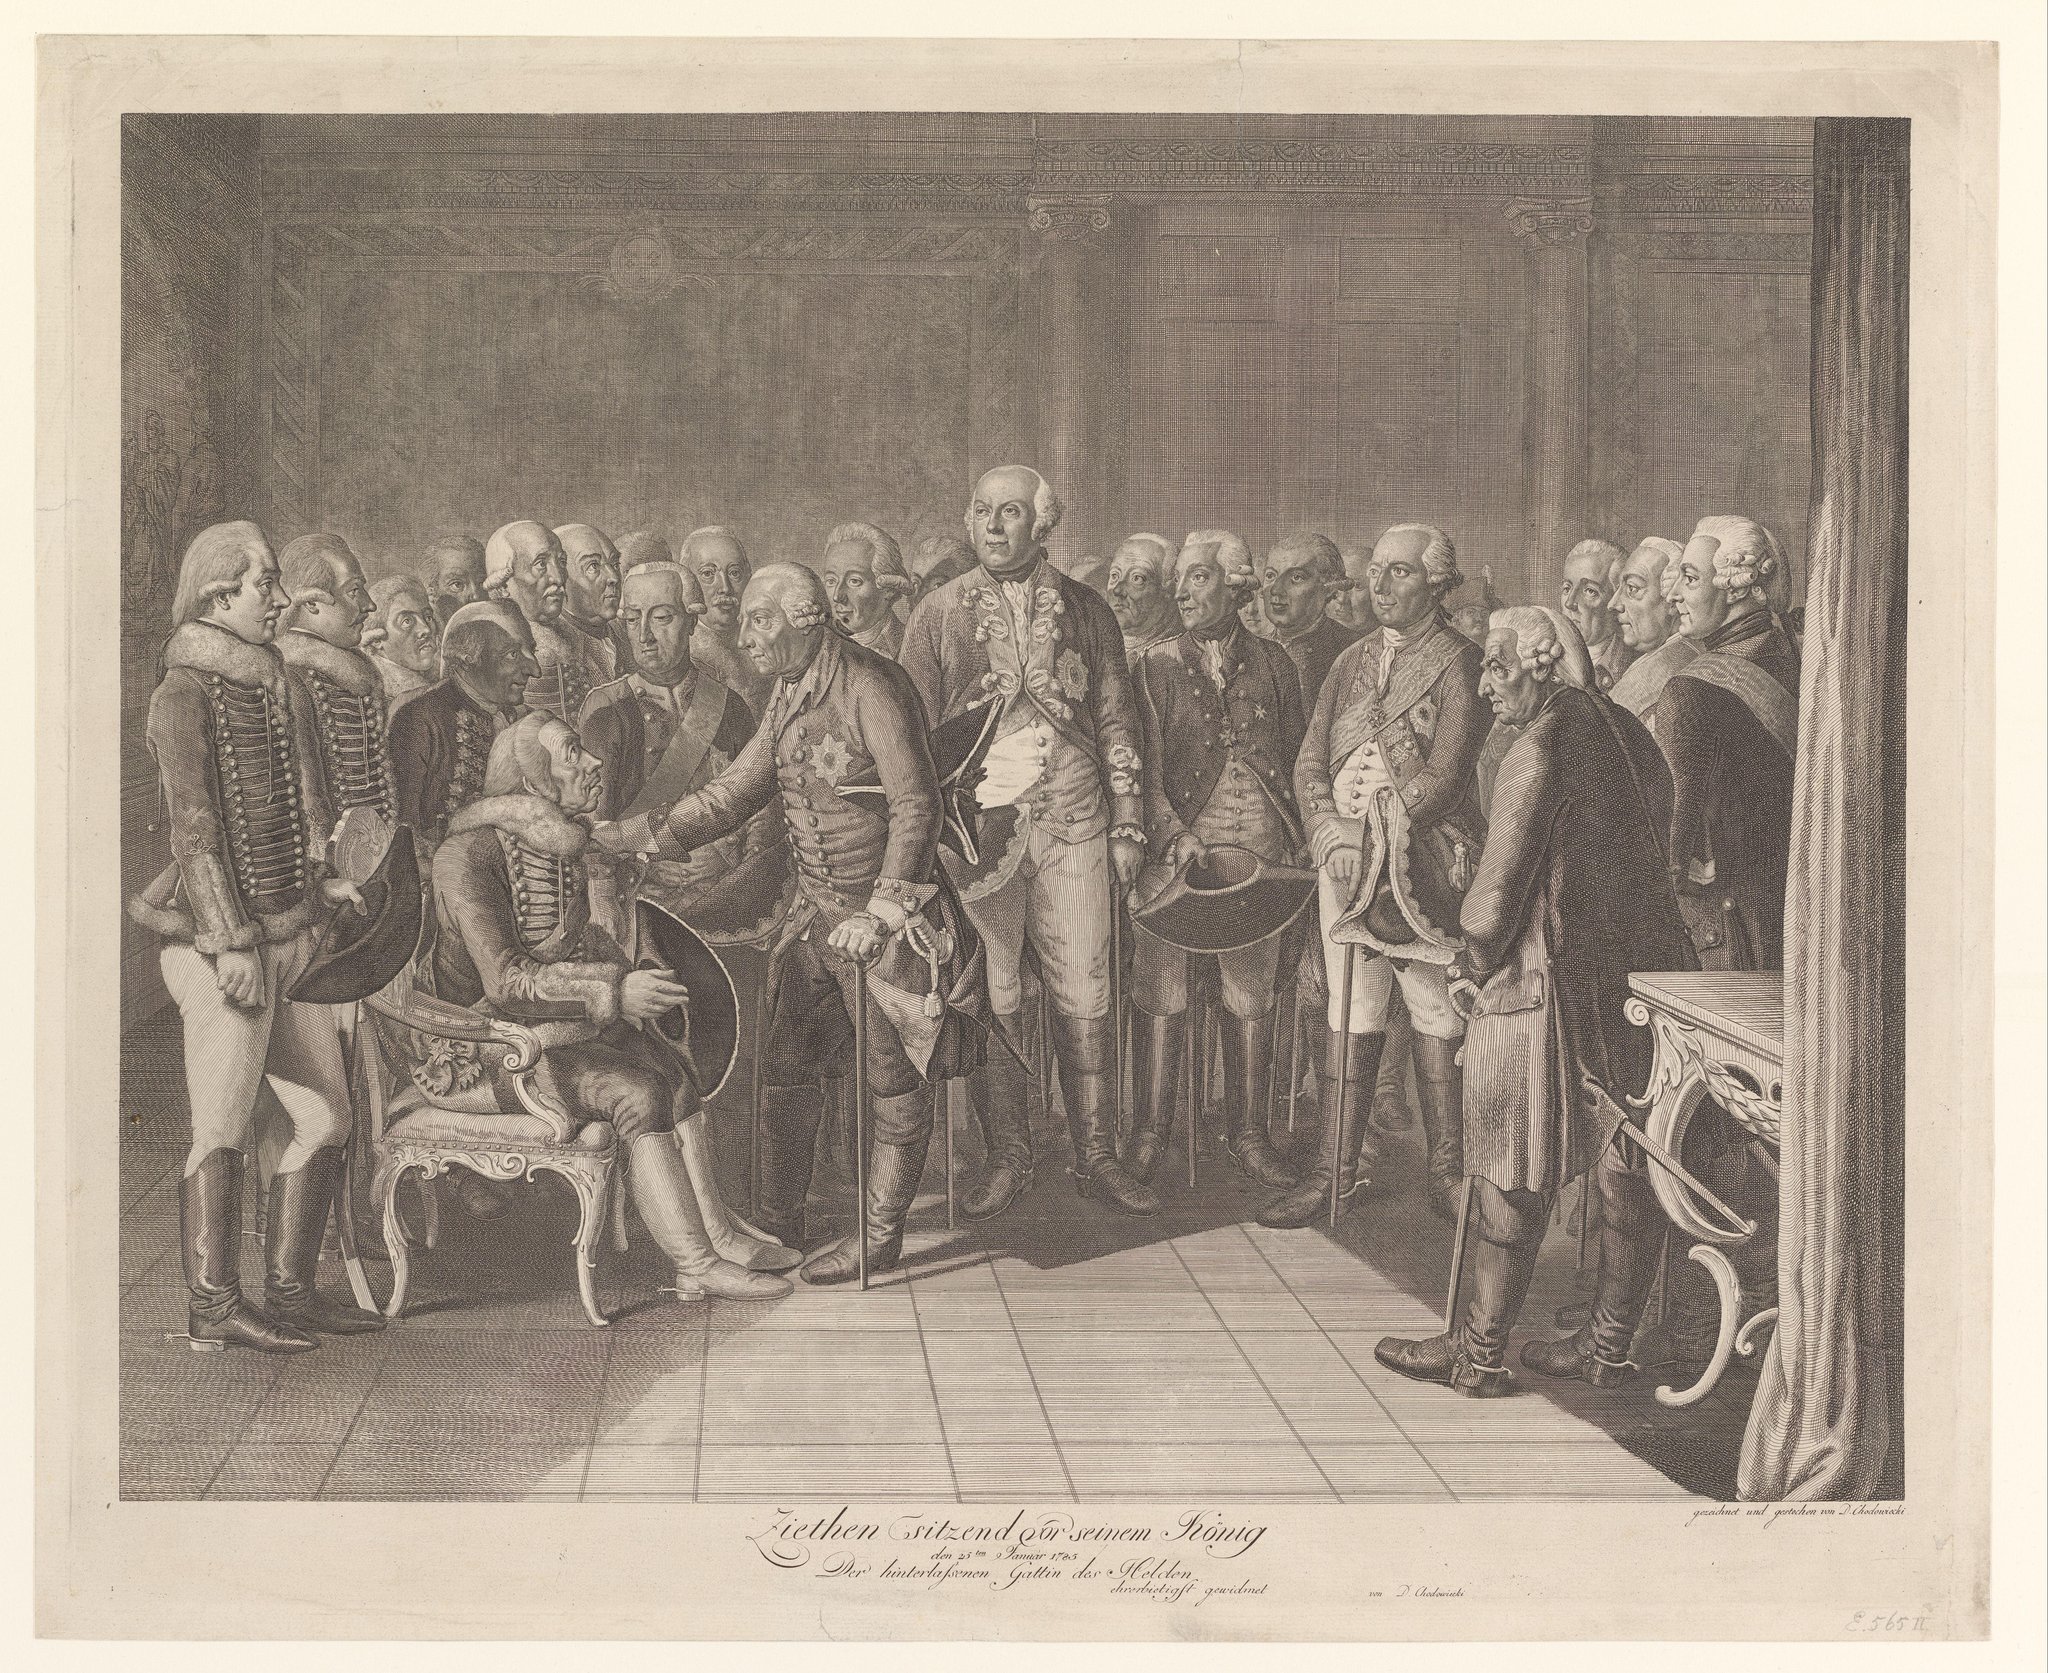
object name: print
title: Ziethen sitzend vor seinem König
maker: daniel nikolaus chodowiecki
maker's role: draughtsman, print maker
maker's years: 1726-1801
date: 1800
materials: paper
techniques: etching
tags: berlin, frederick ii (king of prussia), historical persons, council of war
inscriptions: collector's mark: Lugt 2228